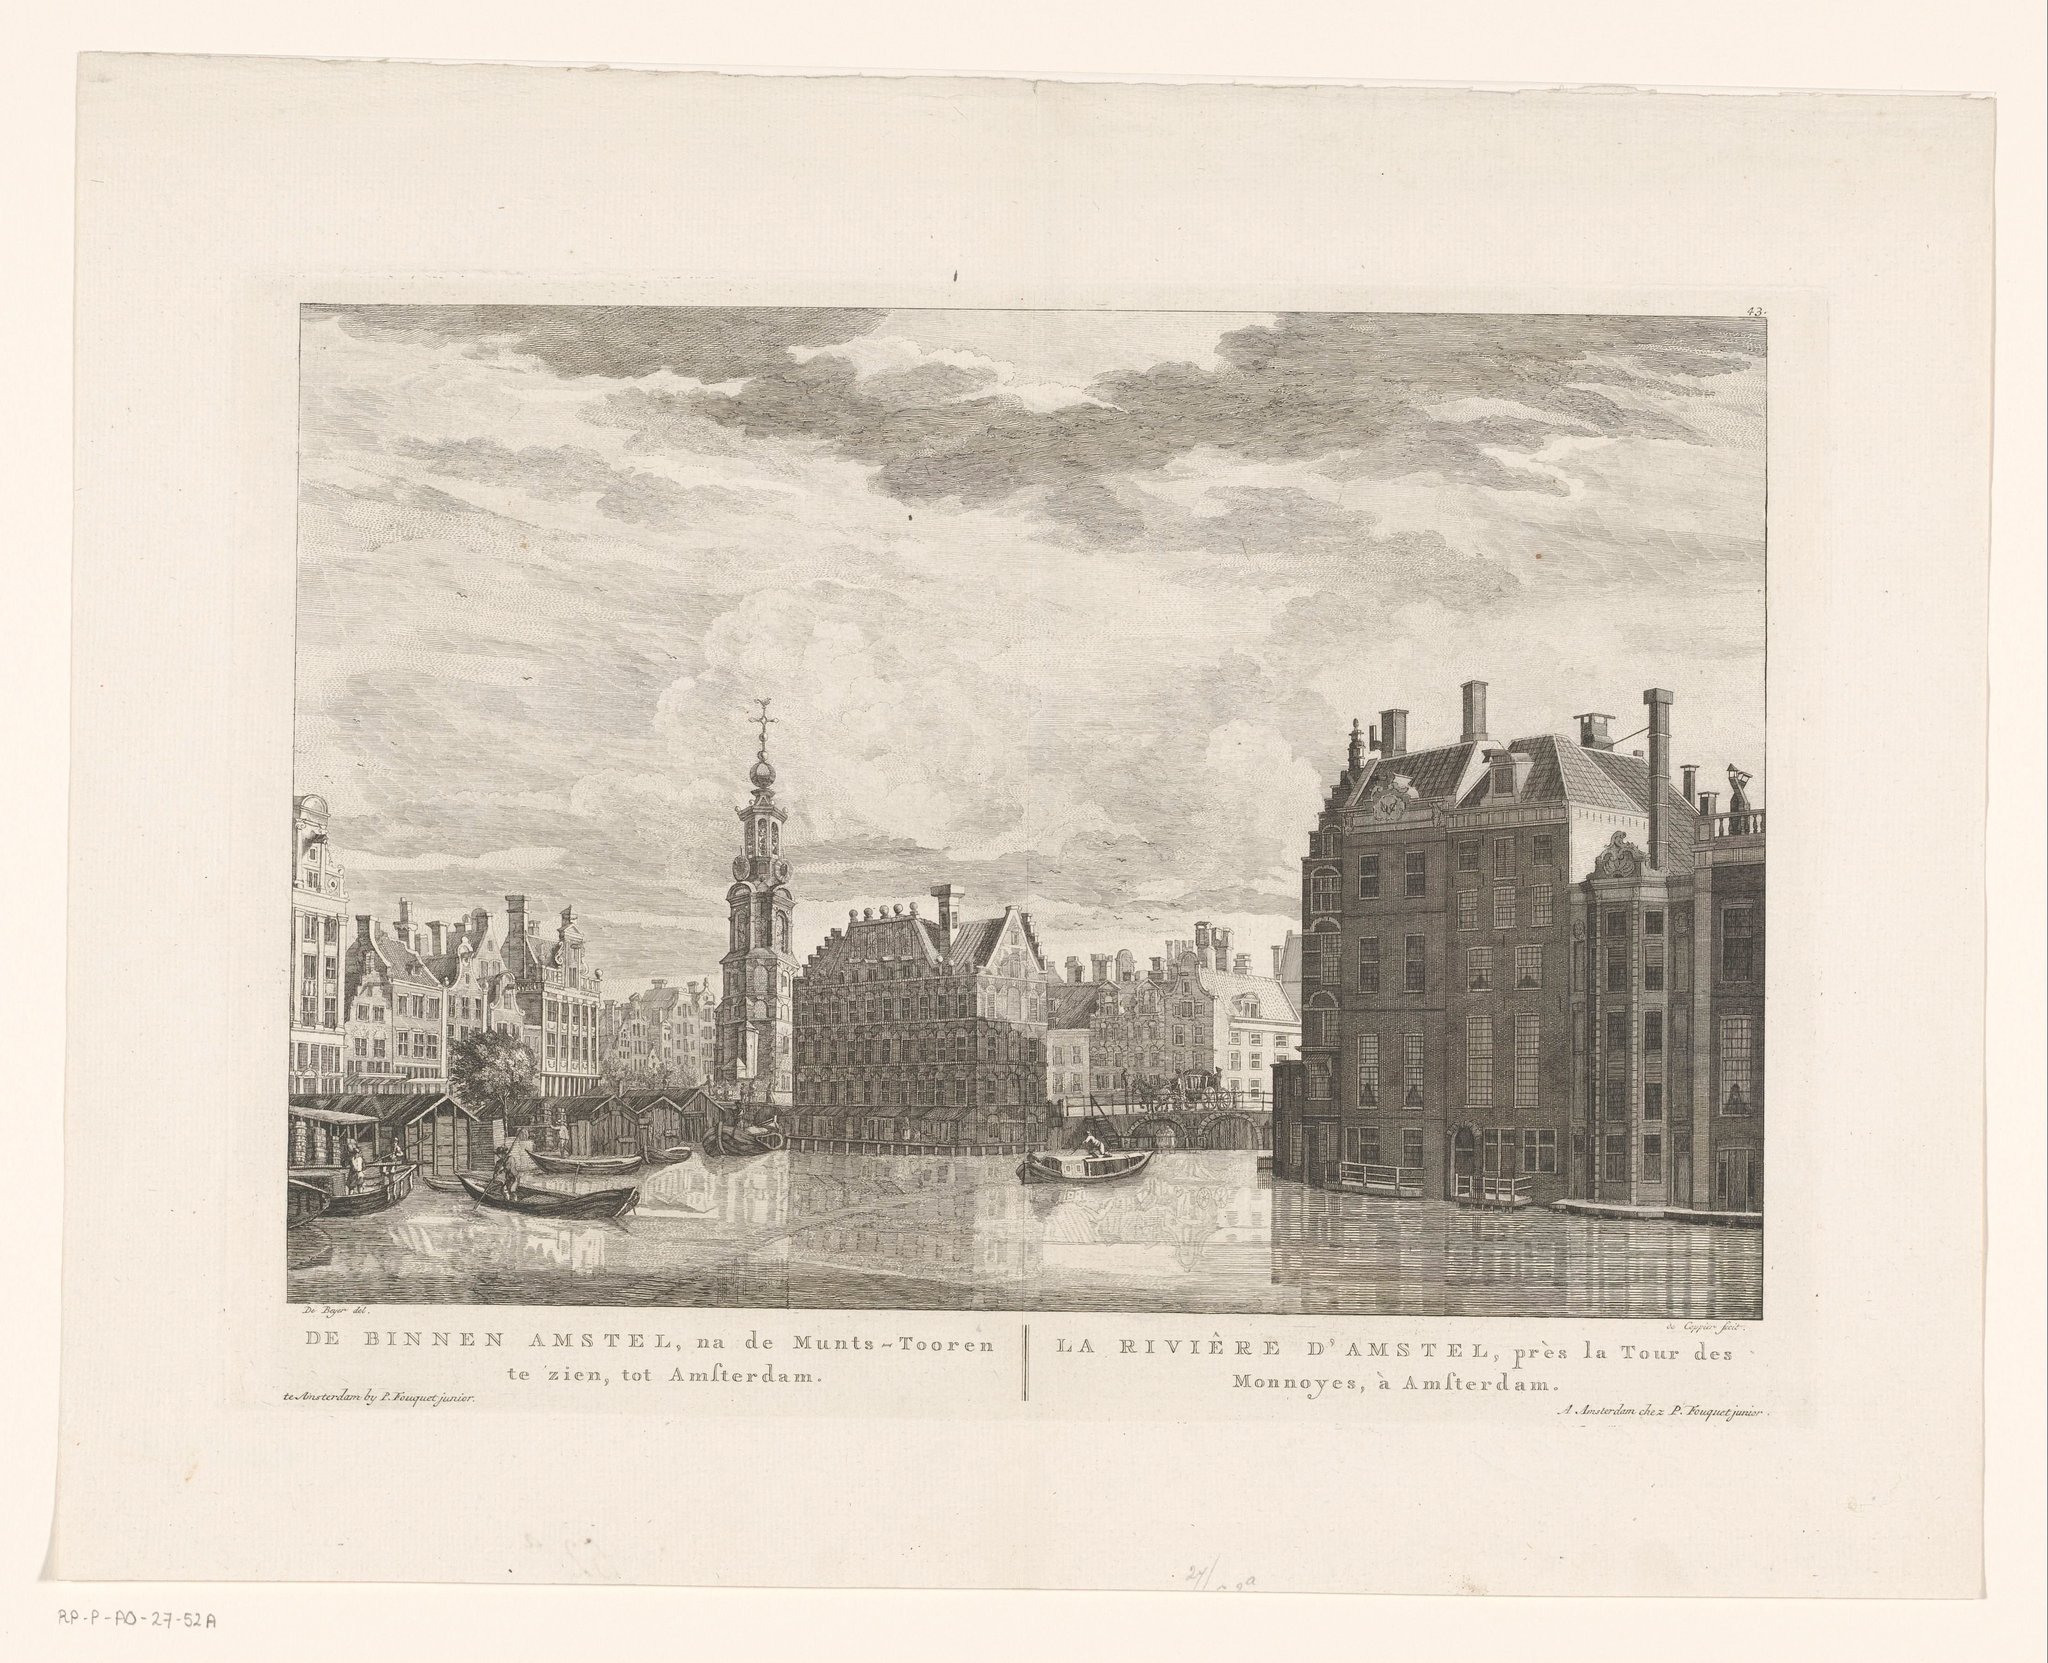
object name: print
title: Gezicht op de Binnen-Amstel en de Munttoren te Amsterdam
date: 1774-1783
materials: paper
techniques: engraving, etching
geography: amsterdam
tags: bridge in city across river, canal, etc. (+ city(-scape) with figures, staffage), tower, clock tower ~ monumental adornment, canals, waters (in city) (+ city(-scape) with figures, staffage)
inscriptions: collector's mark: Lugt 2228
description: Deze prent is ook gebruikt in de zogenaamde Atlas van Fouquet.* Pierre Fouquet gaf vanaf 1760 stadsgezichten van Amsterdam - naar tekeningen van verschillende kunstenaars, gemaakt door verschillende prentmakers - uit. Deze prenten werden aanvankelijk los of in series verkocht. Zoals toen gebruikelijk kon de koper de prenten zelf laten inbinden. Hiertoe gaf Fouquet tussen 1778 en 1783 een titelblad, plattegrond en inhoudsopgave van de tot dusver 100 uitgegeven prenten uit (1). Gezien de inhoud afhankelijk was van wat de koper had verzameld verschilt de inhoud van de verschillende bewaarde Fouquetatlassen onder deze titel sterk. Ook zijn er exemplaren bekend waar tevens andere prenten aan zijn toegevoegd. Omdat er behoefte bleek aan uitleg bij de platen werd in 1783 een nieuwe versie van de atlas uitgegeven, aangevuld met tekst en twee prenten. De aangegeven volgorde veranderde maar de platen van de al eerder uitgegeven prenten bleven ongewijzigd. Deze uitgave werd in opdracht van Fouquet gedrukt bij Daniël Jean Changuion en Petrus den Hengst (2). Een tiental platen werd bijgewerkt en verscheen, met nieuw impressum, in het vervolg van Wagenaars geschiedenis van Amsterdam, uitgeven door Petrus Conradi en Folkert van der Plaats (3). Een aantal jaar na het overlijden van Fouquet kwam Evert Maaskamp met een nieuwe uitgave van de atlas, met verbeterde tekst en toevoeging van twee prenten. Op alle platen verwijderde hij het oude en liet hij zijn eigen impressum zetten (4). De huidige staat van de prent komt voor in exemplaren van de onder (1) en (2) genoemde werken. * Onder de Atlas van Fouquet of Fouquetatlas verstaan we de hieronder vermelde publicaties (1), (2) en (4). (1). Afbeeldingen van de wyd-vermaarde koopstad Amsterdam benevens des zelvs voornaamste gebouwen en gezigten alle naar het leeven getekend / Receuil des edifices les plus considerables et des plus belles vues, de la fameuse ville d'Amsterdam, dessinées d'après nature. Amsterdam: Pierre Fouquet, 1778-1783. (2). Nieuwe atlas, van de voornaamste gebouwen en gezigten der stad Amsterdam, met derzelver beknopte beschryvingen. 2 delen. Amsterdam: Daniël Jean Changuion en Petrus den Hengst [in opdracht van Pierre Fouquet], 1783. (3). Stijl, Simon. Amsterdam, in zyne geschiedenissen, voorregten, koophandel, gebouwen, kerkenstaat, schoolen, schutterye, gilden en regeeringe, beschreeven. Om te dienen ten vervolge op het werk van Jan Wagenaar (…). 10 delen. Amsterdam en Harlingen: Petrus Conradi en Folkert van der Plaats, 1788-1801. (4). Nieuwe atlas, van de voornaamste gebouwen en gezigten der stad Amsterdam. Met derzelver beknopte beschryvingen. Amsterdam: Evert Maaskamp, 1805. * Het aantal vermelde staten is gebaseerd op het aantal gevonden staten. Mogelijk zijn er meer staten van deze prent. Voor eerste bekende staat RP-P-1921-303. Voor tweede of derde bekende staat zie RP-P-1905-388.